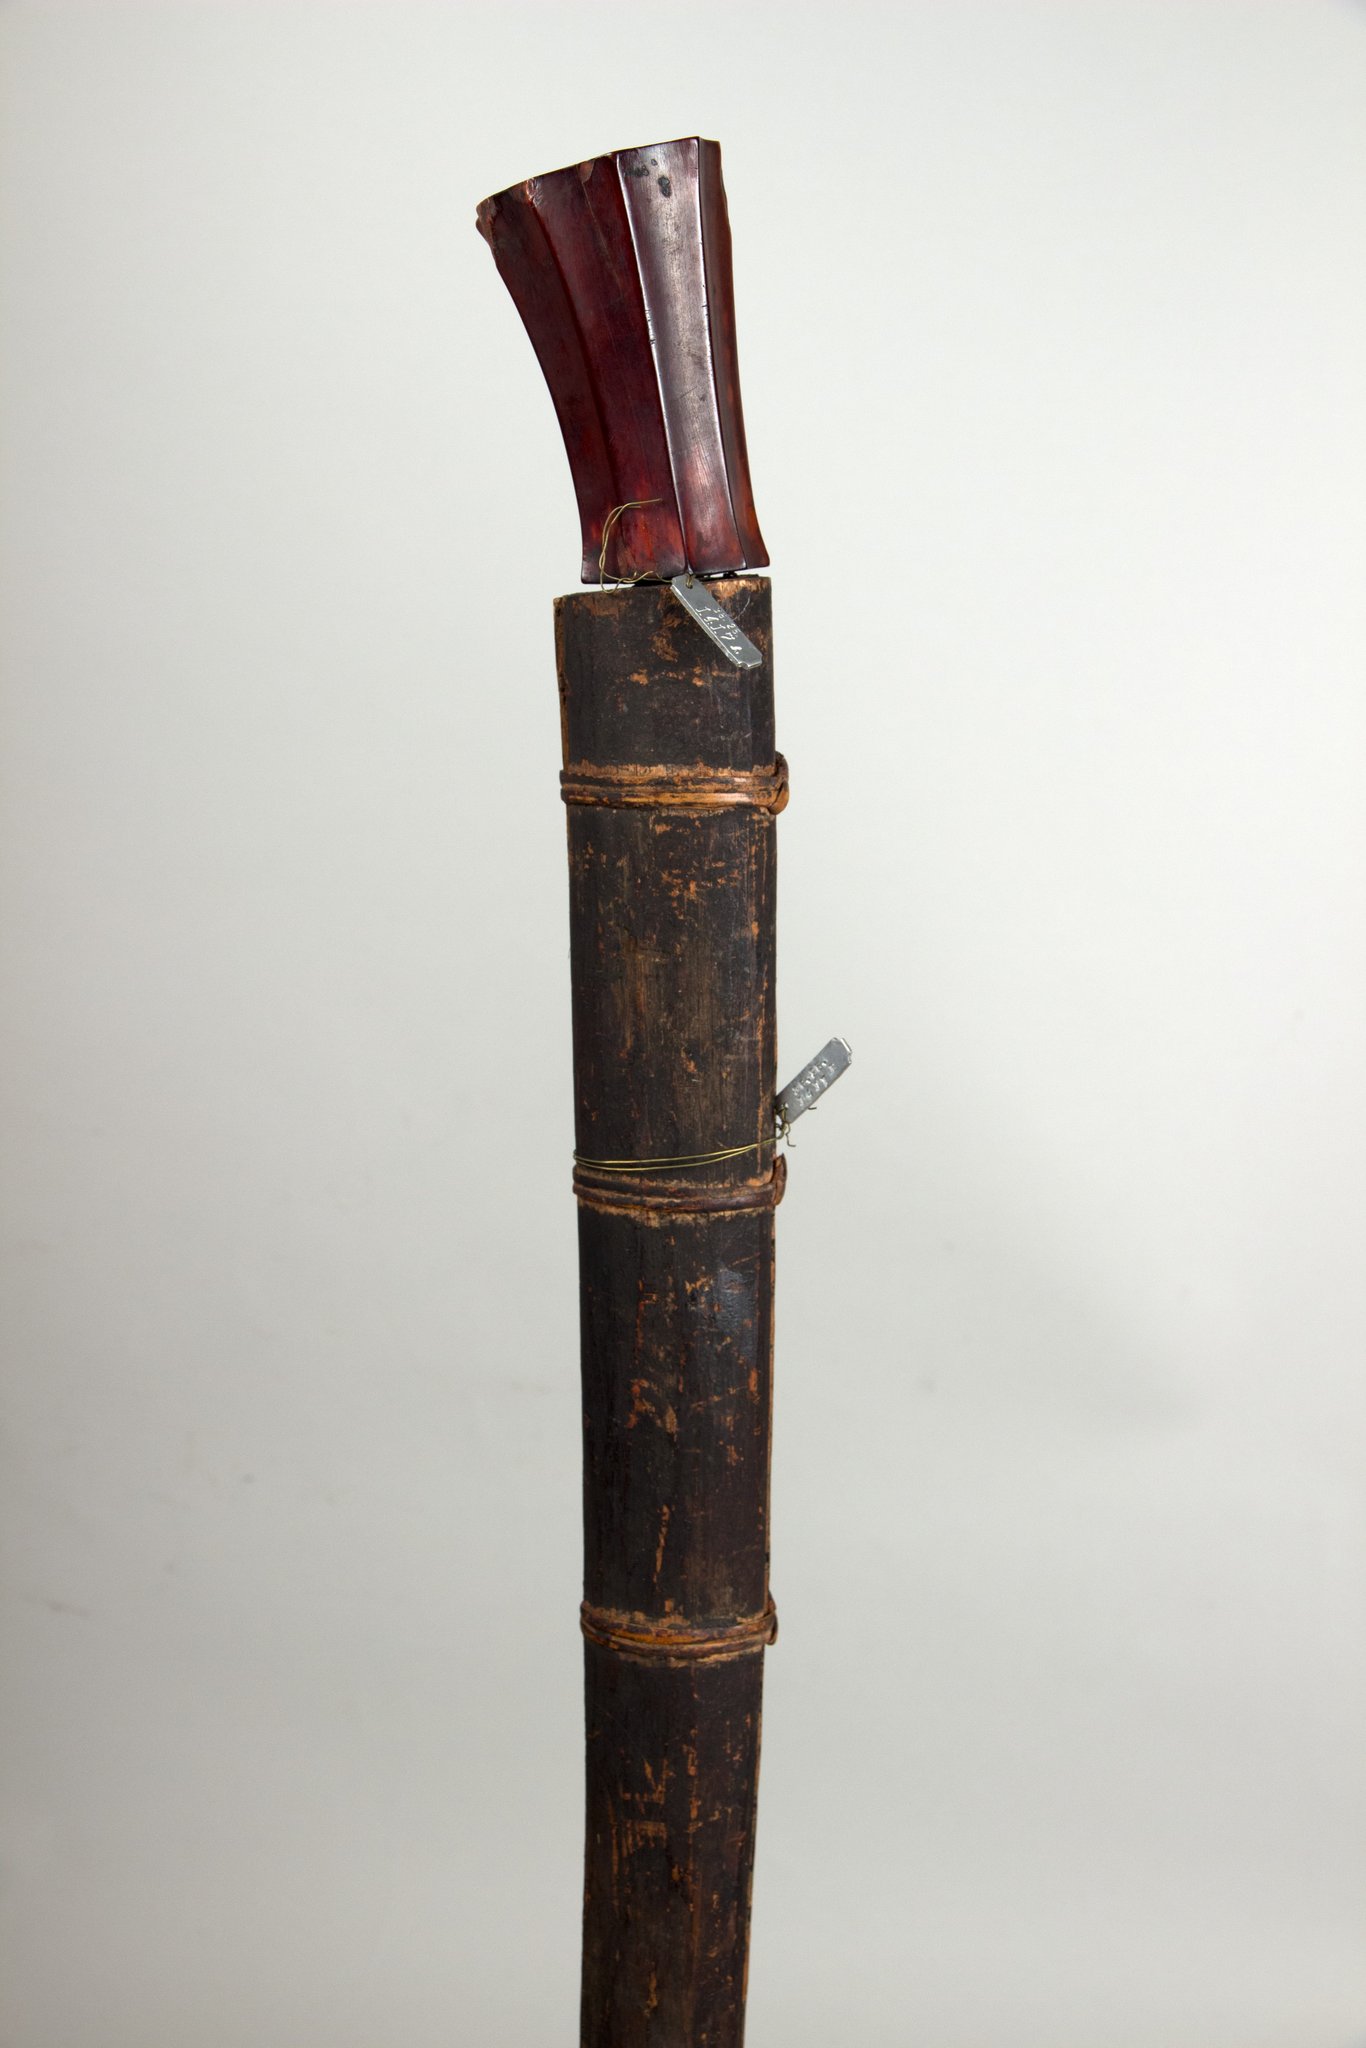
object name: sword with scabbard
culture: batak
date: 1501-1900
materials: ivory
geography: indonesia